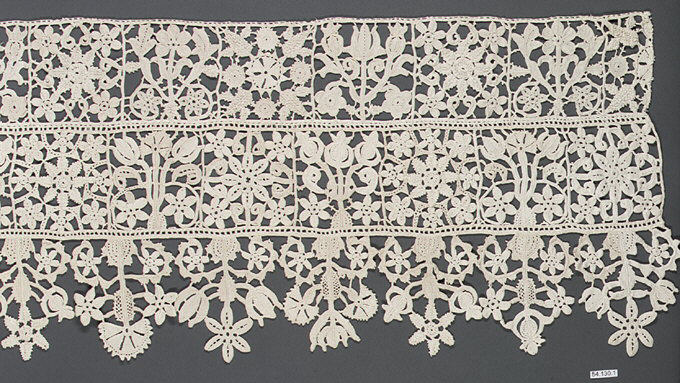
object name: border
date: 1601-1633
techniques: lace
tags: flowers